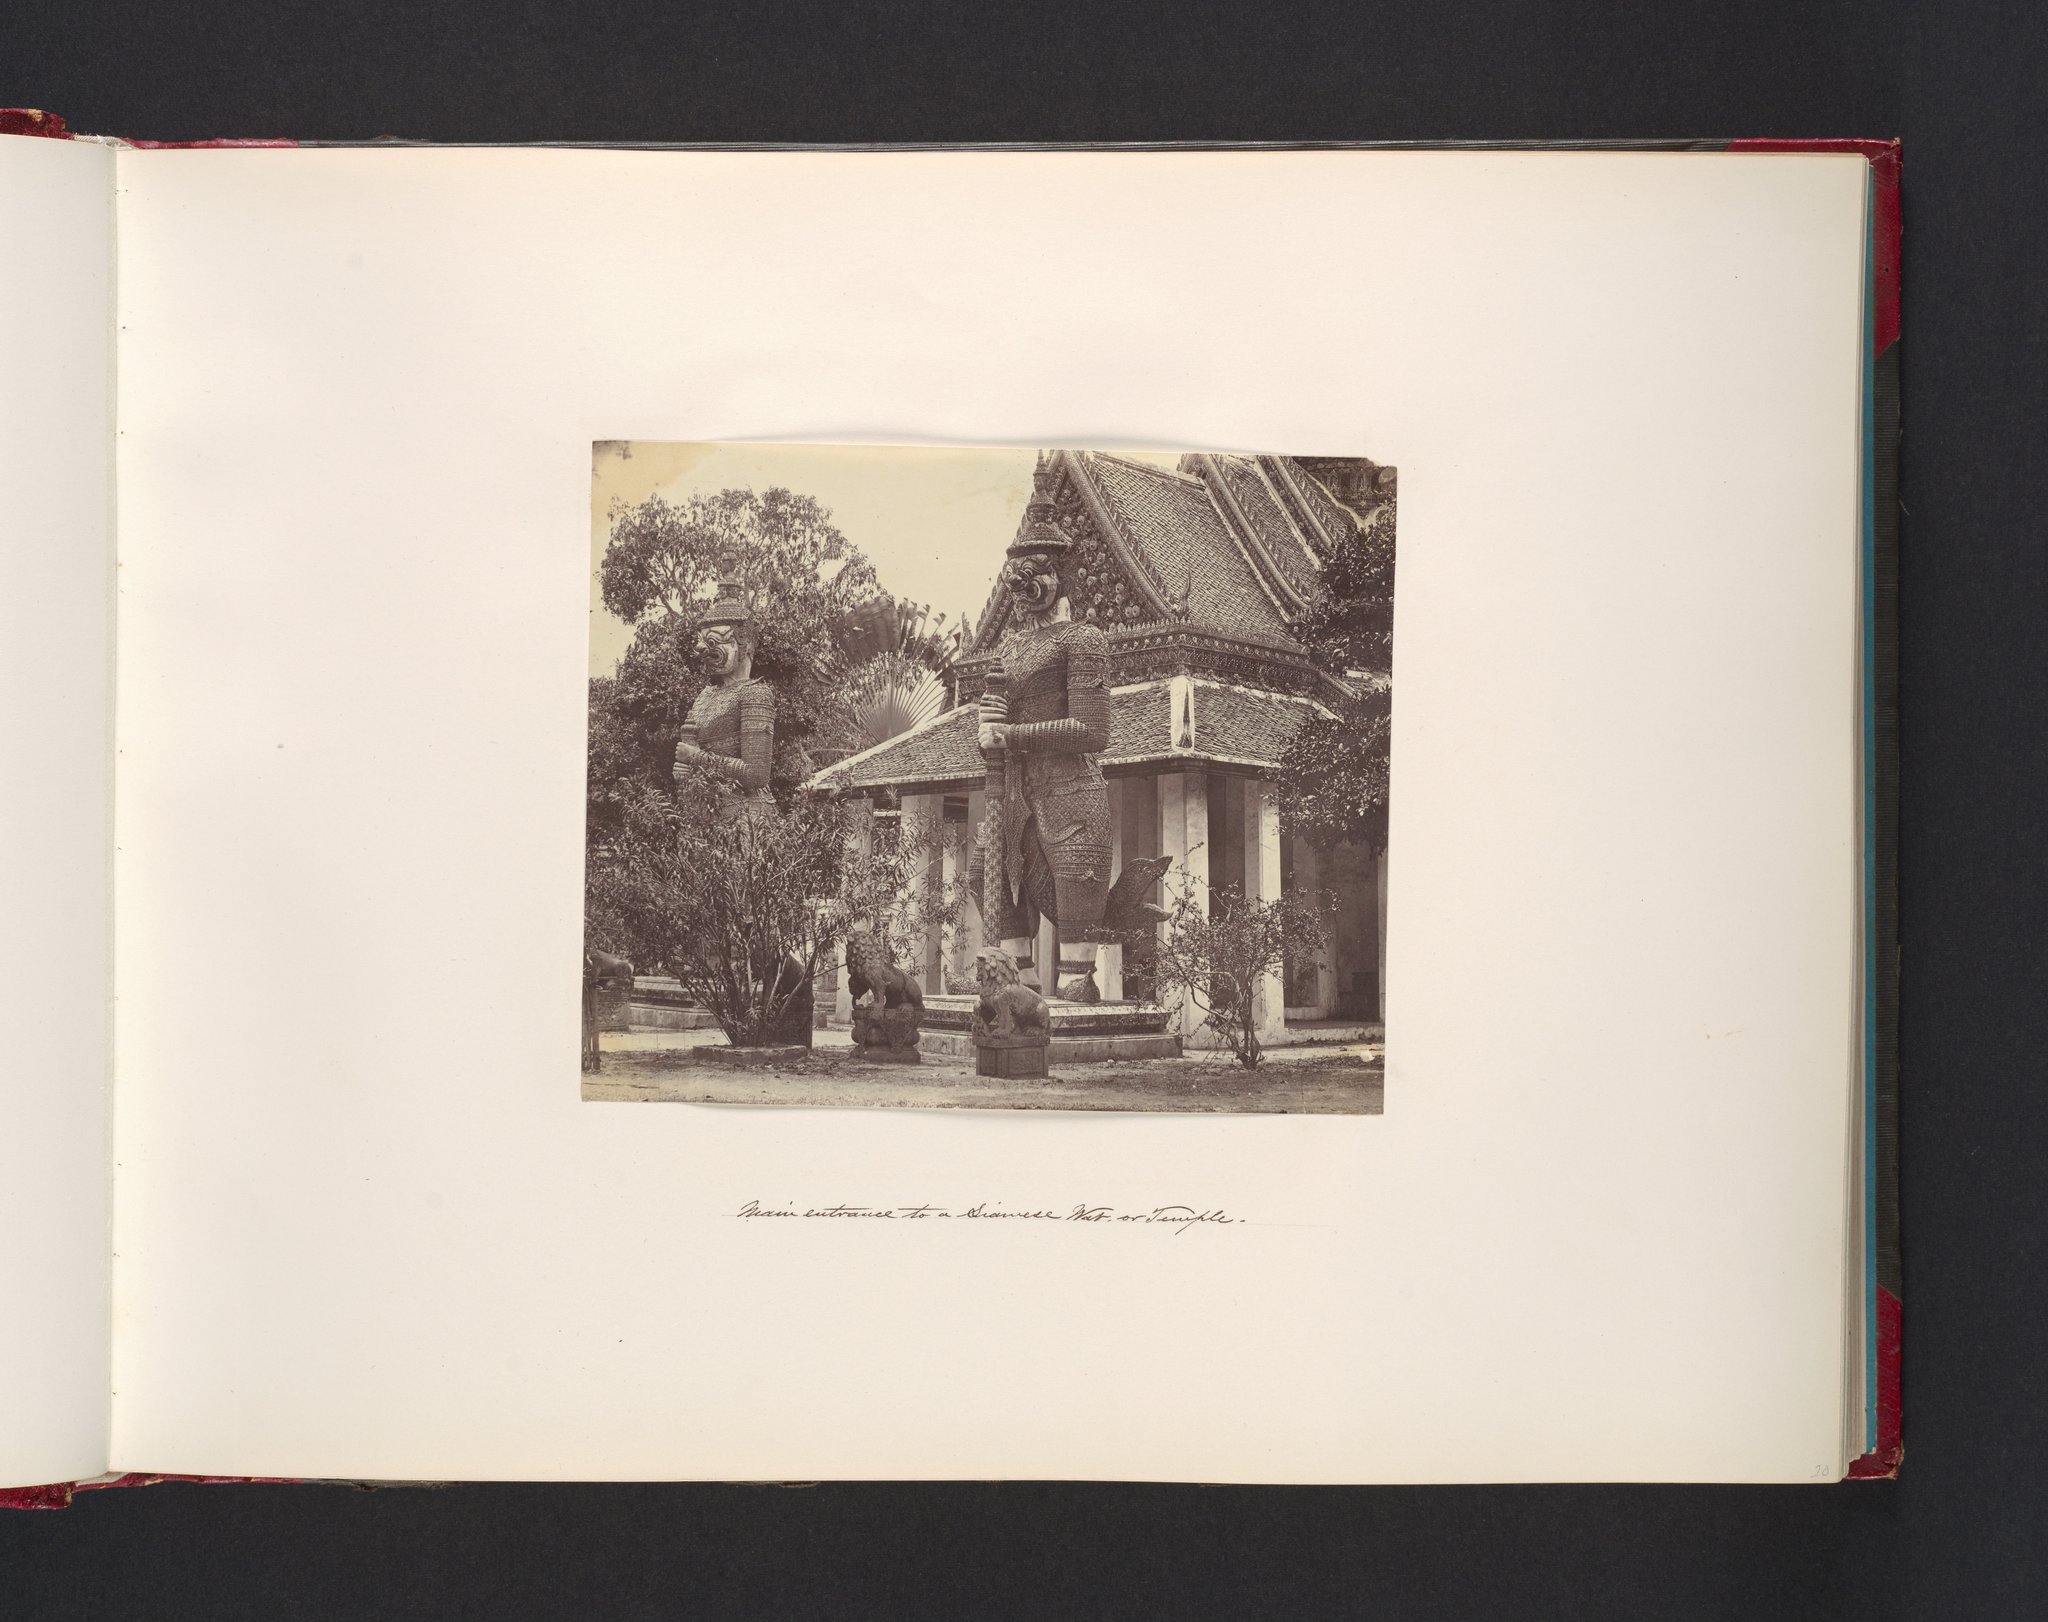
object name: photograph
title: Main Entrance to a Siamese Wat or Temple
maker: john thomson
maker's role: artist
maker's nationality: british, scottish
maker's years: 1837-1921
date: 1865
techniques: albumen silver print, glass negative